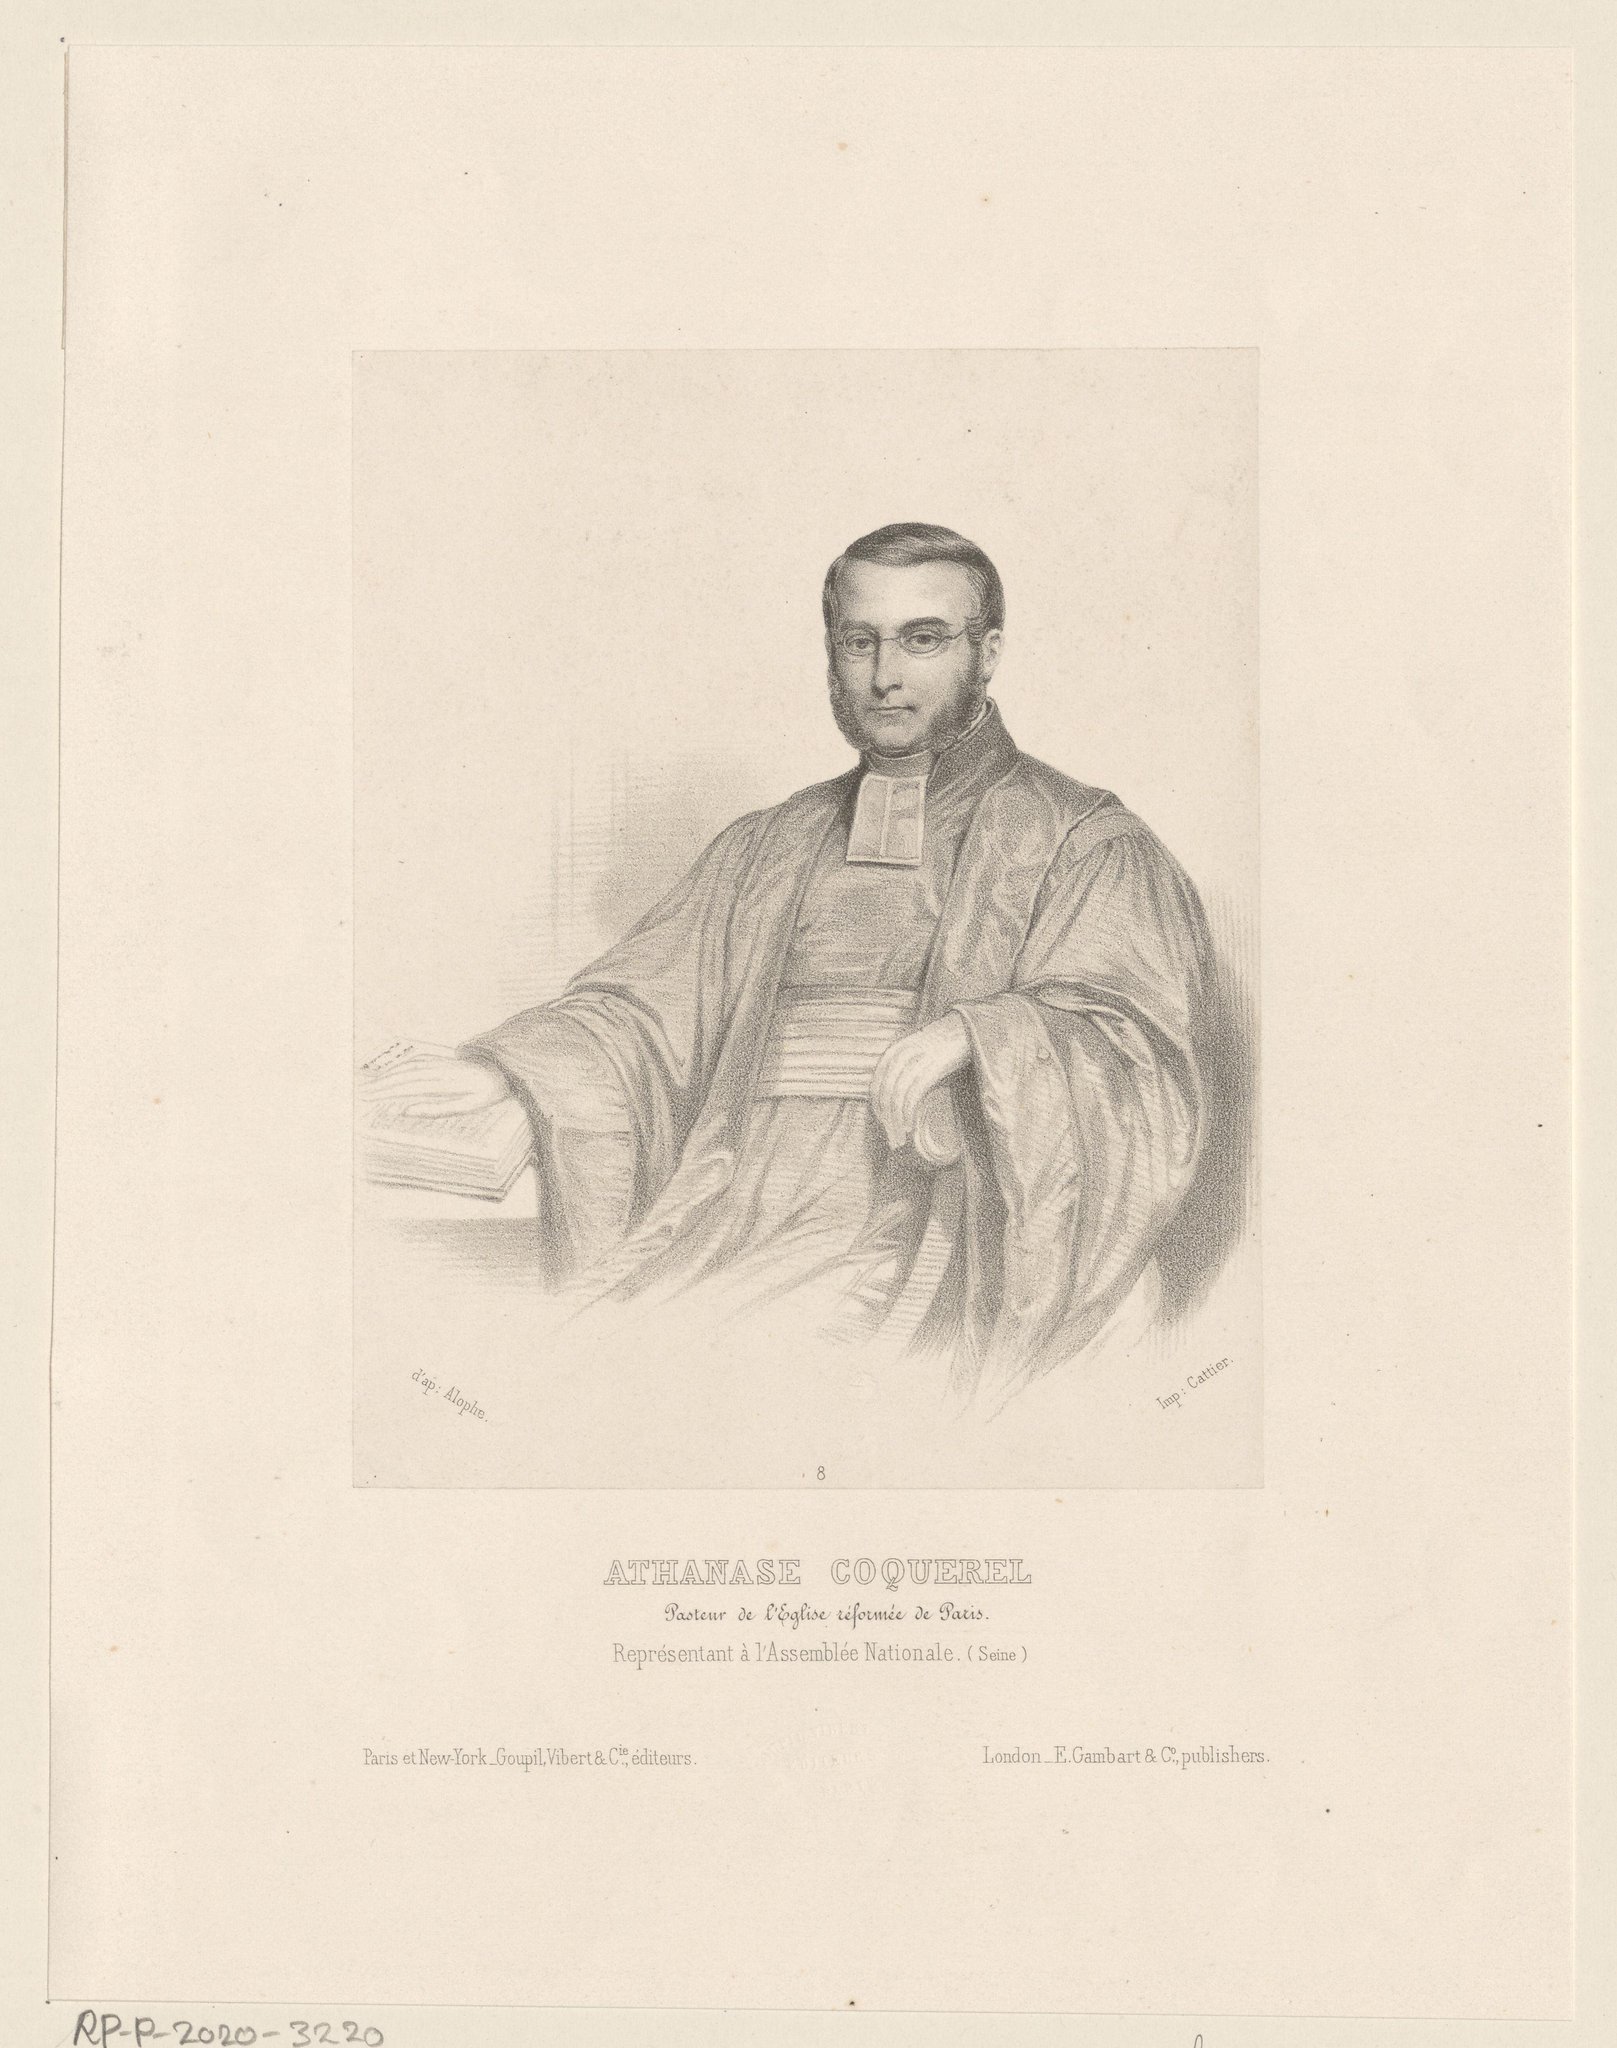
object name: print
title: Représentant à l'Assemblée Nationale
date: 1841-1850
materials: paper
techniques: lithograph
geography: new york city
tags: historical persons